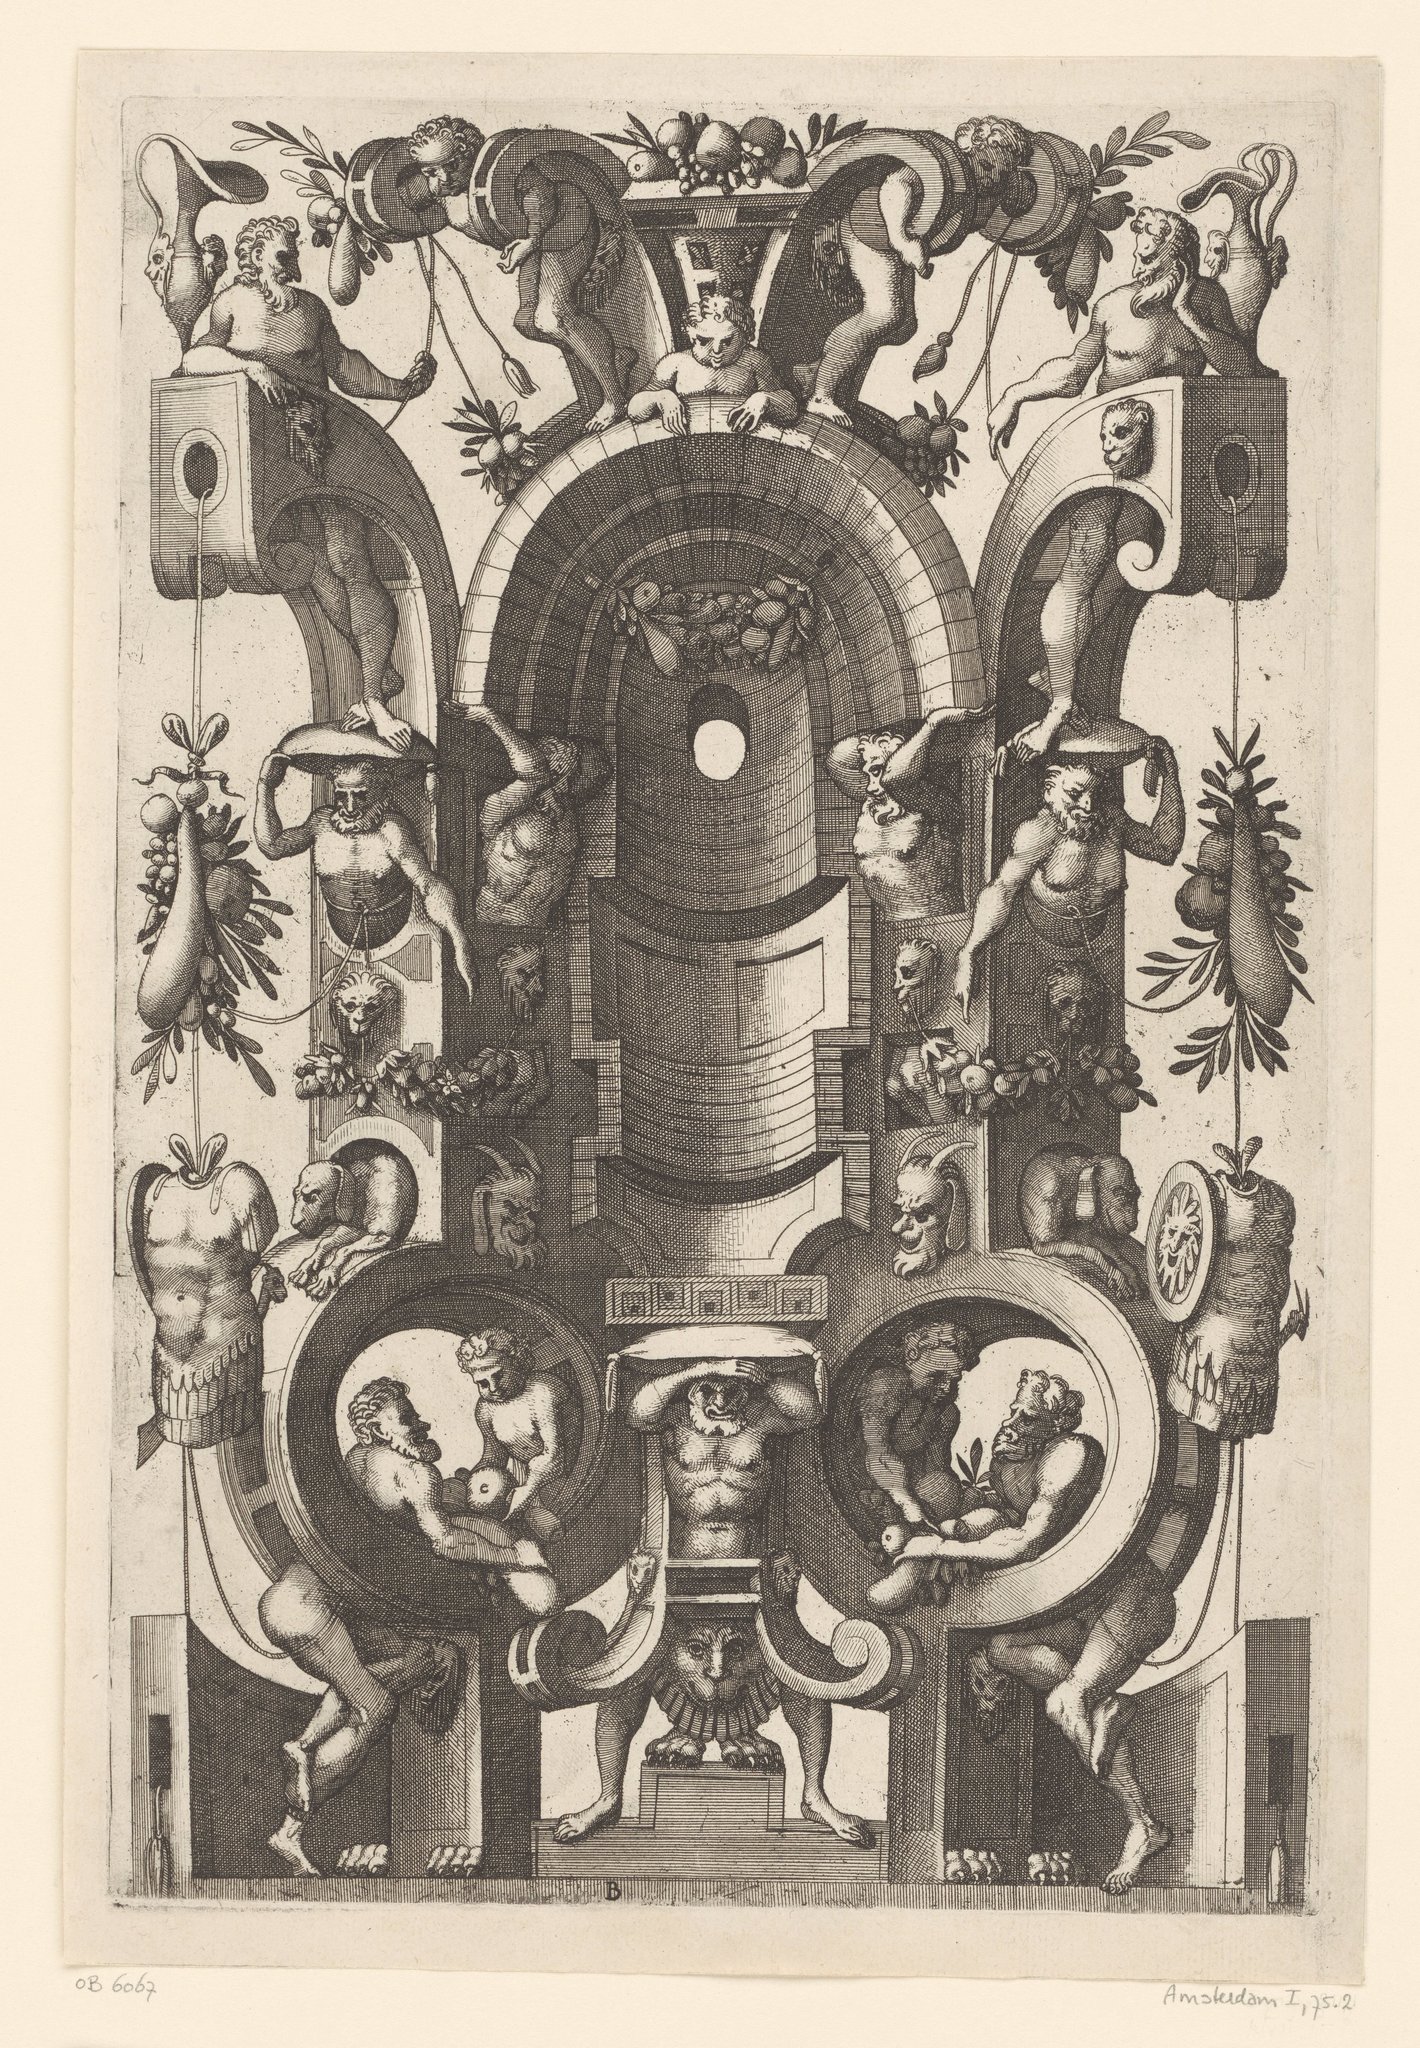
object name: ornament print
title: Veelderleij Veranderinghe van grotissen ende Compertimenten (...)Libro Primo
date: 1556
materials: paper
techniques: etching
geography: netherlands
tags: ornament ~ grotesque, atlantes ~ architecture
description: Aan weerszijden van atlant rolwerk met voluut waar een man doorheen leunt. In de voluut een kind. Blad B afkomstig uit serie van 12 bladen, genummerd A-M met vlakdecoraties van grotesken met rolwerk, saters, guirlandes, trofeeën, dieren en fantasiewezens.